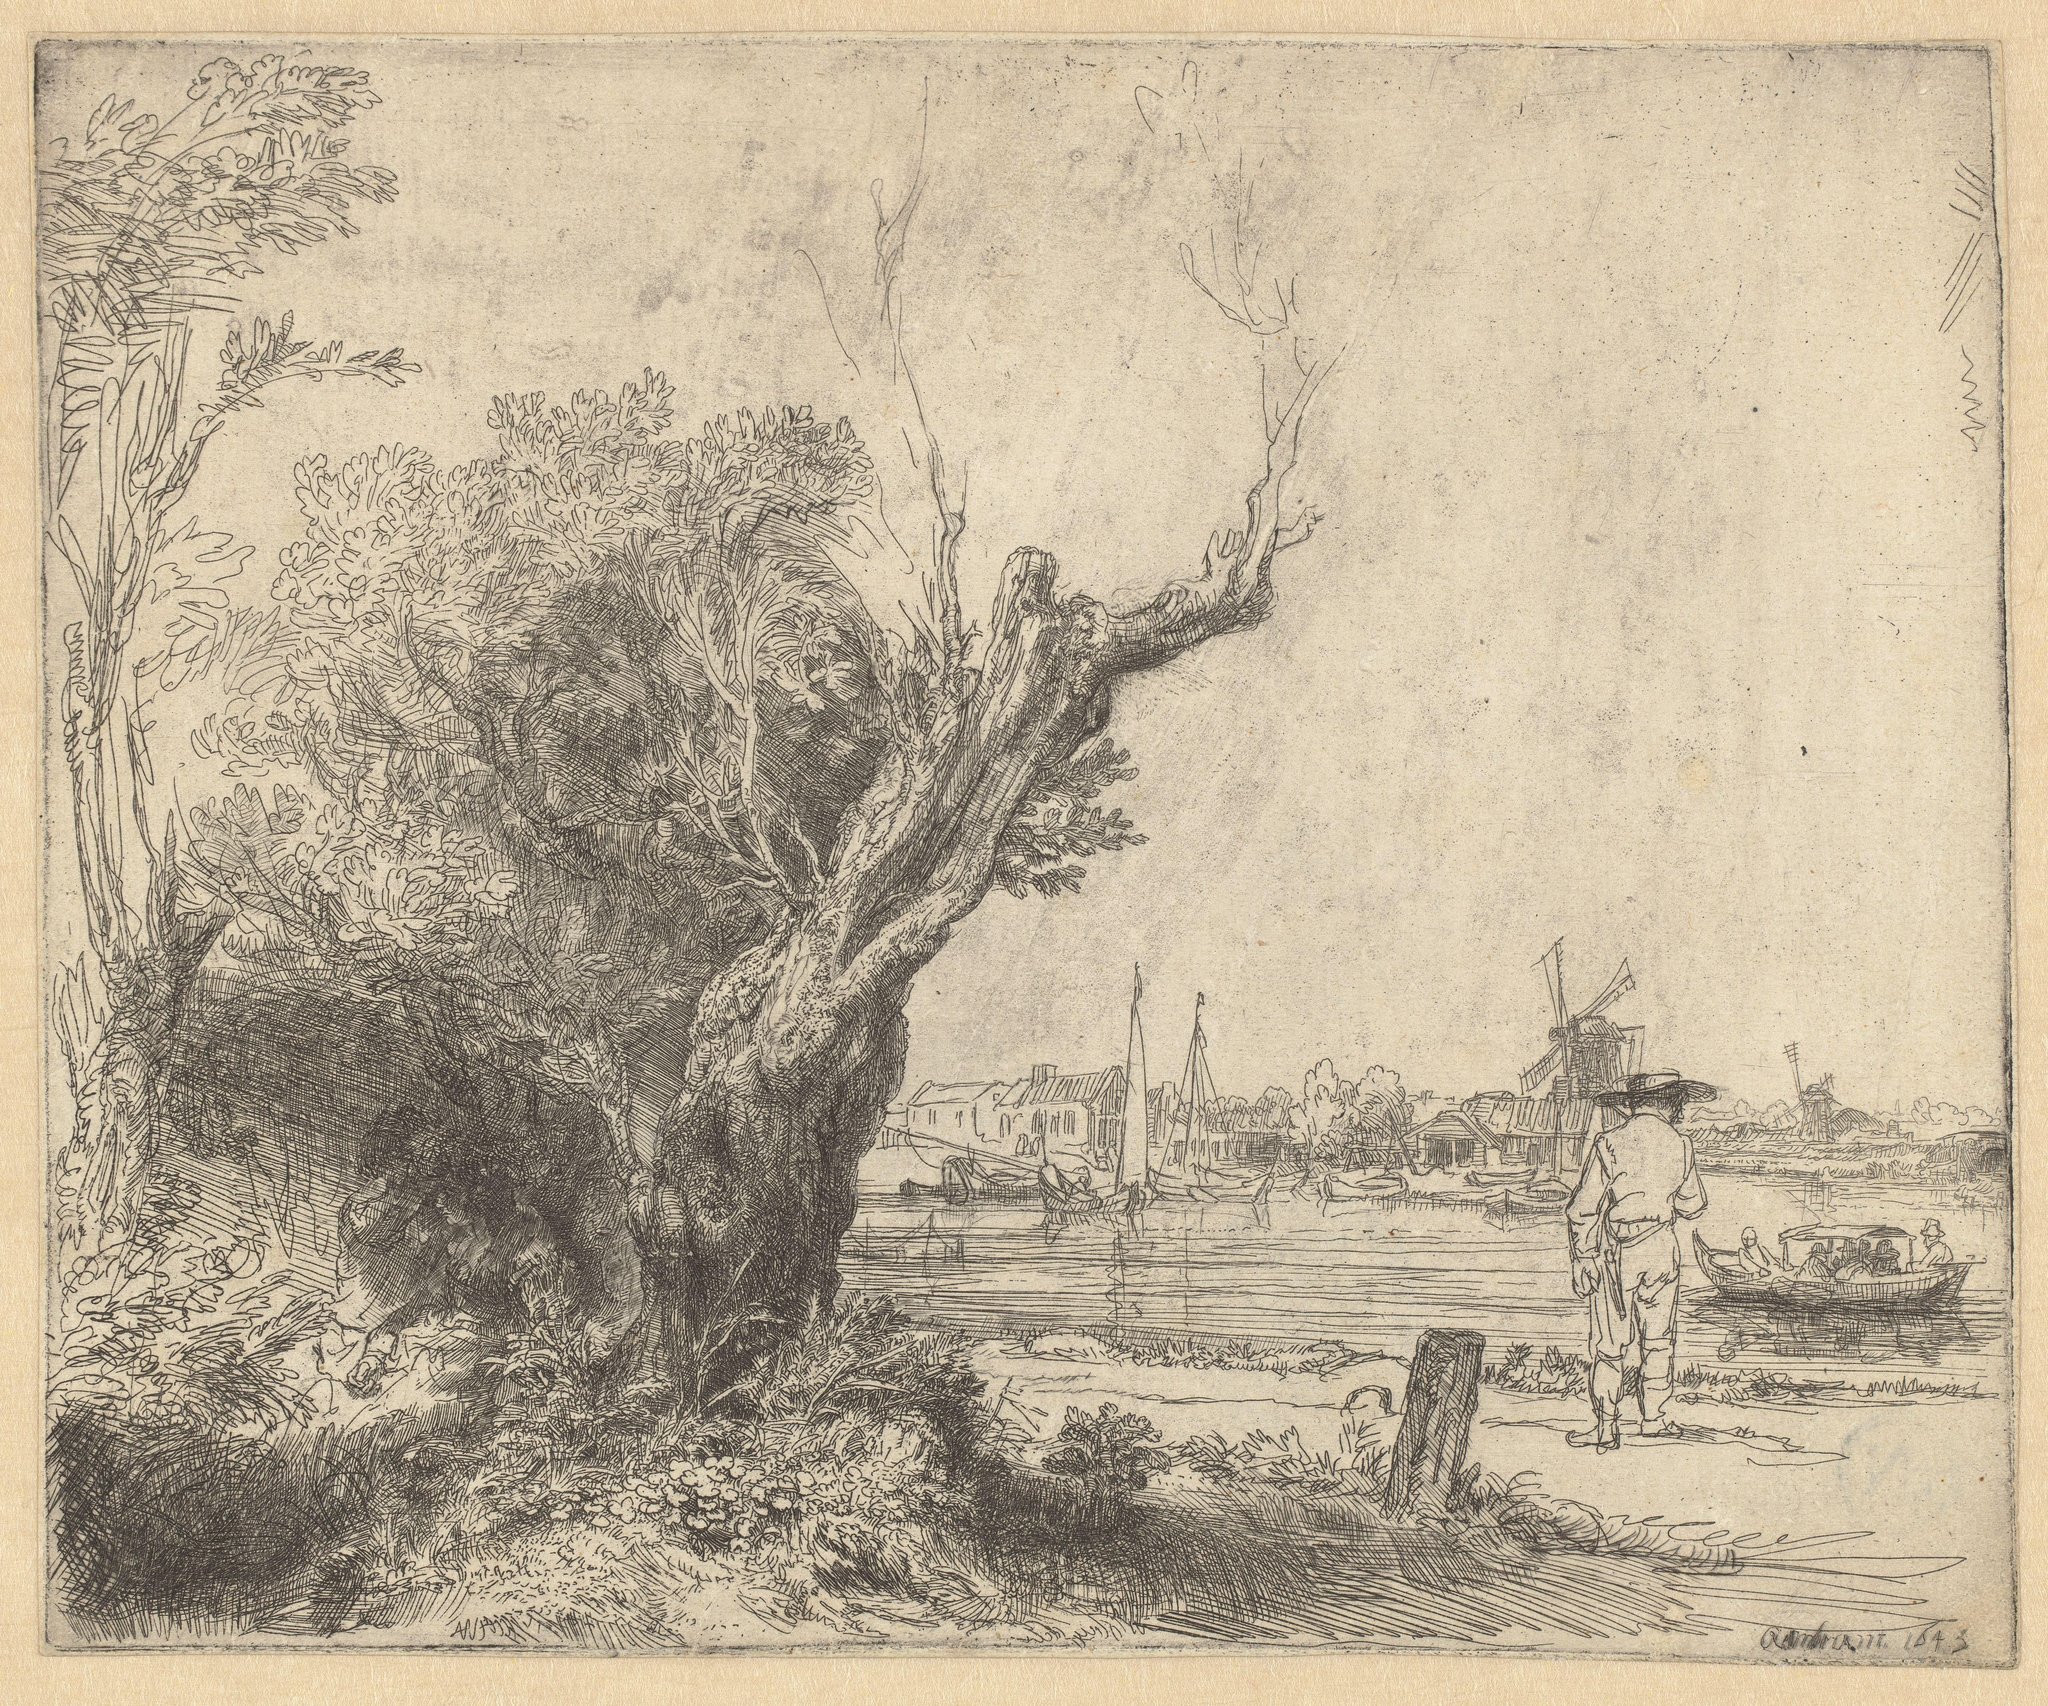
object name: print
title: The Omval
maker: rembrandt van rijn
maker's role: draughtsman, painter, print maker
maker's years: 1606-1669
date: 1645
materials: paper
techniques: drypoint, etching, intaglio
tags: omval, de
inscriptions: signature and date: ‘Rembrant. 1645’, collector's mark: Lugt 2398, collector's mark: Lugt 1681, collector's mark: ‘1883’ Lugt 1610, collector's mark: Lugt 1454 c, collector's mark: Lugt 1606, collector's mark: Lugt 2228 a, collector's mark: Lugt 2482, collector's mark: Lugt 2529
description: Rembrandt’s contemporaries would have instantly recognized the spot depicted in this print. This piece of land was called The Omval, after a ruin once located there. On the other side of the Amstel River is the dike near the Watergraafsmeer. Underneath a finely detailed pollard willow, Rembrandt depicted a man lovingly placing a wreath of flowers on a woman’s head.